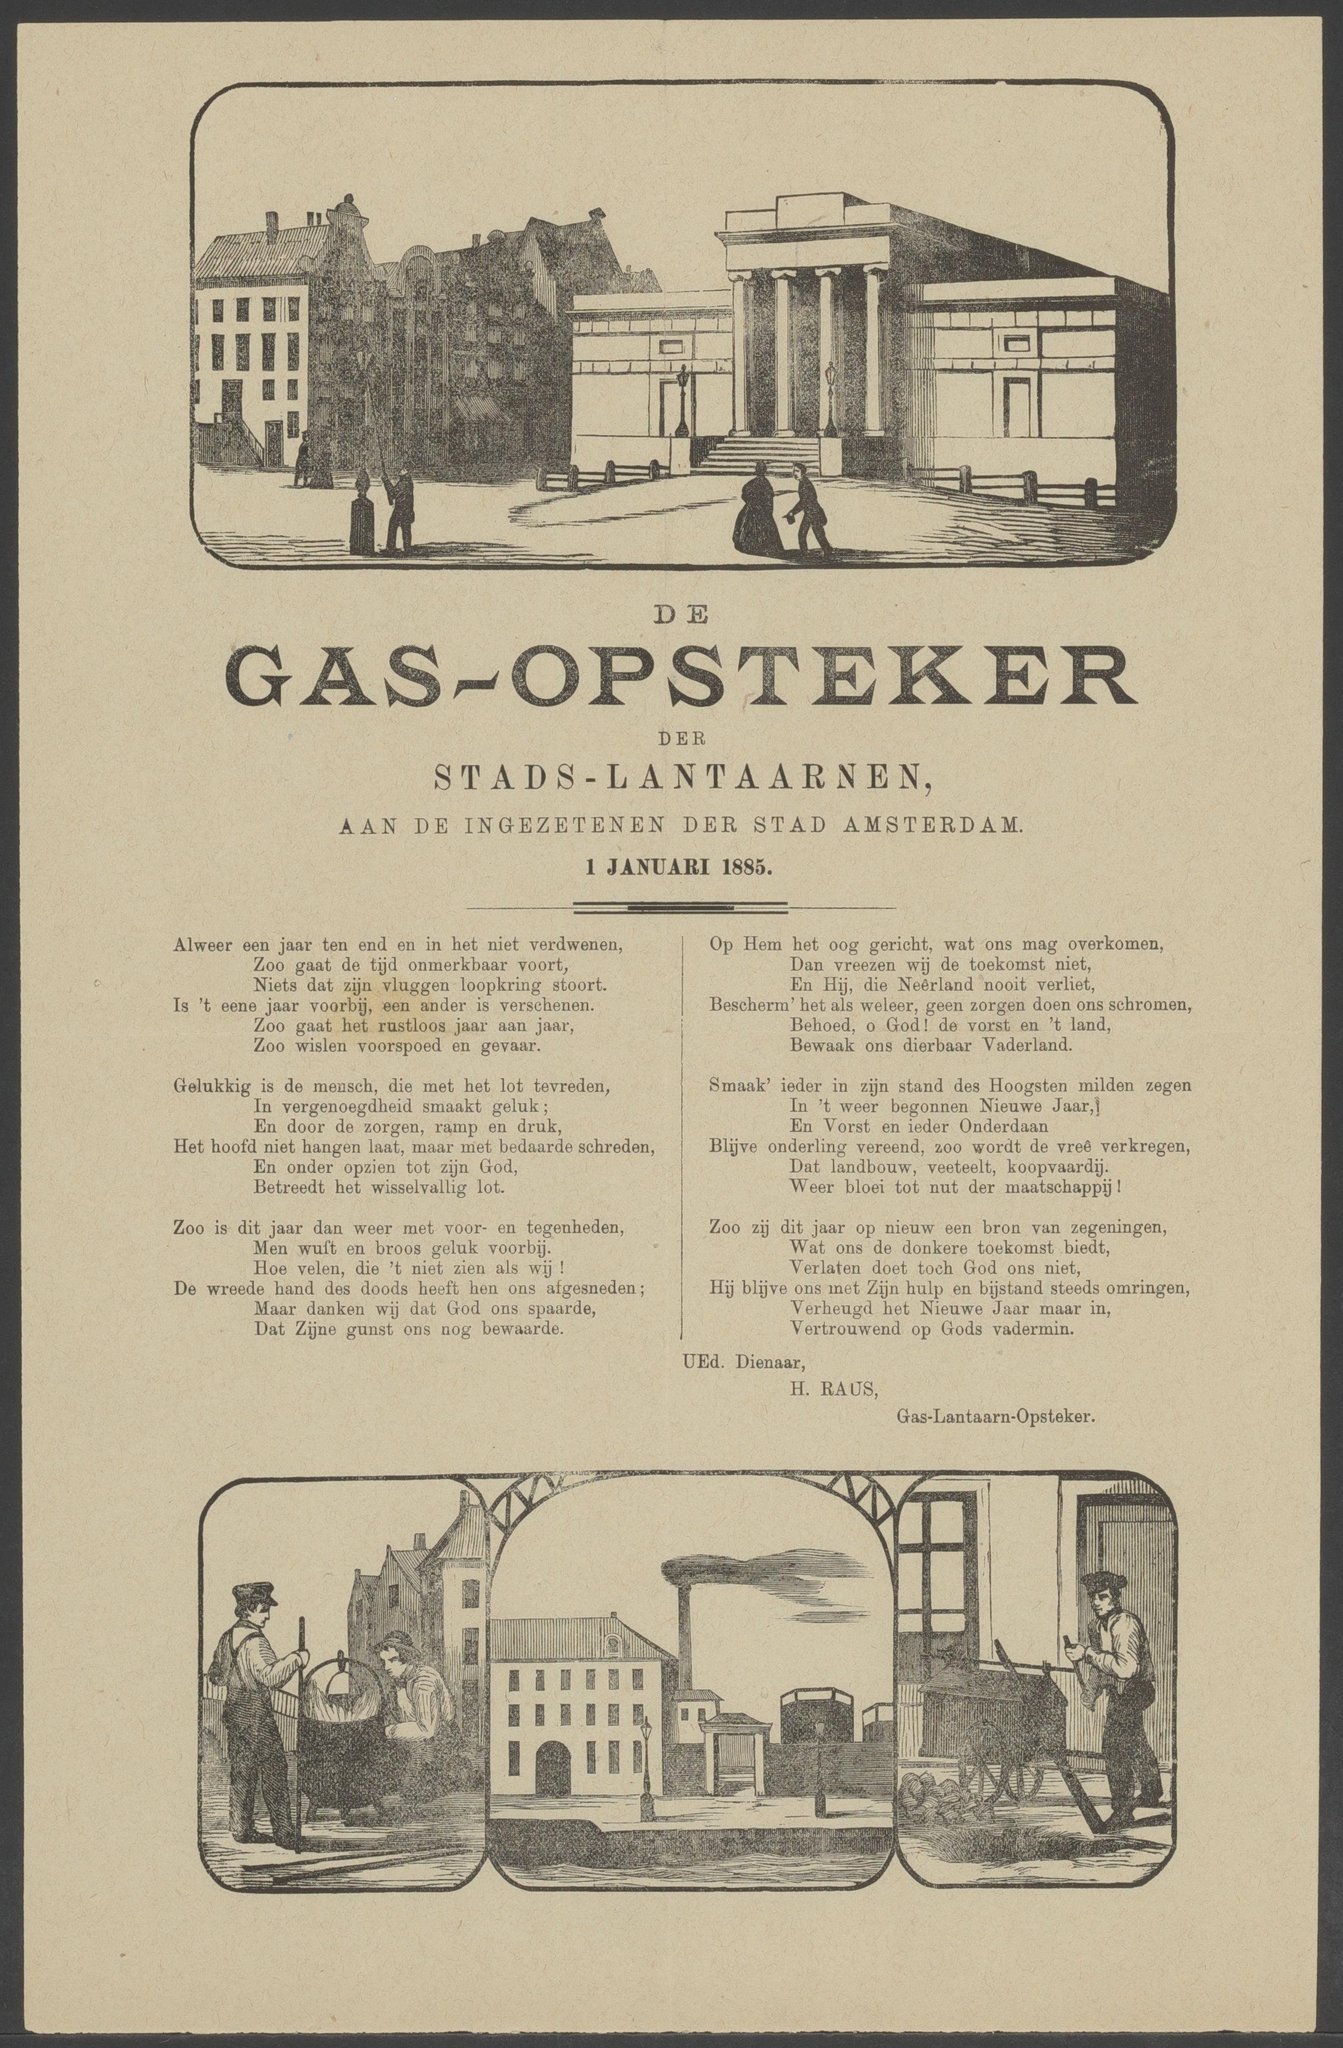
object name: print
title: Nieuwjaarswens van de gaslantaarnopstekers van Amsterdam voor het jaar 1885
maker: Anonymous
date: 1884-1885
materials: paper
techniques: letterpress printing, engraving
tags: gas-lamp, gas supply, digging (industrial process), street lighting, amsterdam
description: Nieuwjaarswens van de Amsterdamse gaslantaarnopstekers voor het jaar 1885. Centraal een vers in twee kolommen. Bovenaan de Dam met de beurs van Zocher te Amsterdam. Onderaan de Hollandsche Gasfabriek en twee gasfitters aan het werk. Van de gaslantaarnopsteker: H. Raus. Onderwerpsrubrieken binnen de Atlas Zeden en Gewoonten: Zeden en gewoonten in engeren zin, Volksleven, Volksbladen, Nieuwjaars- en Kerstwenschen, Amsterdam.